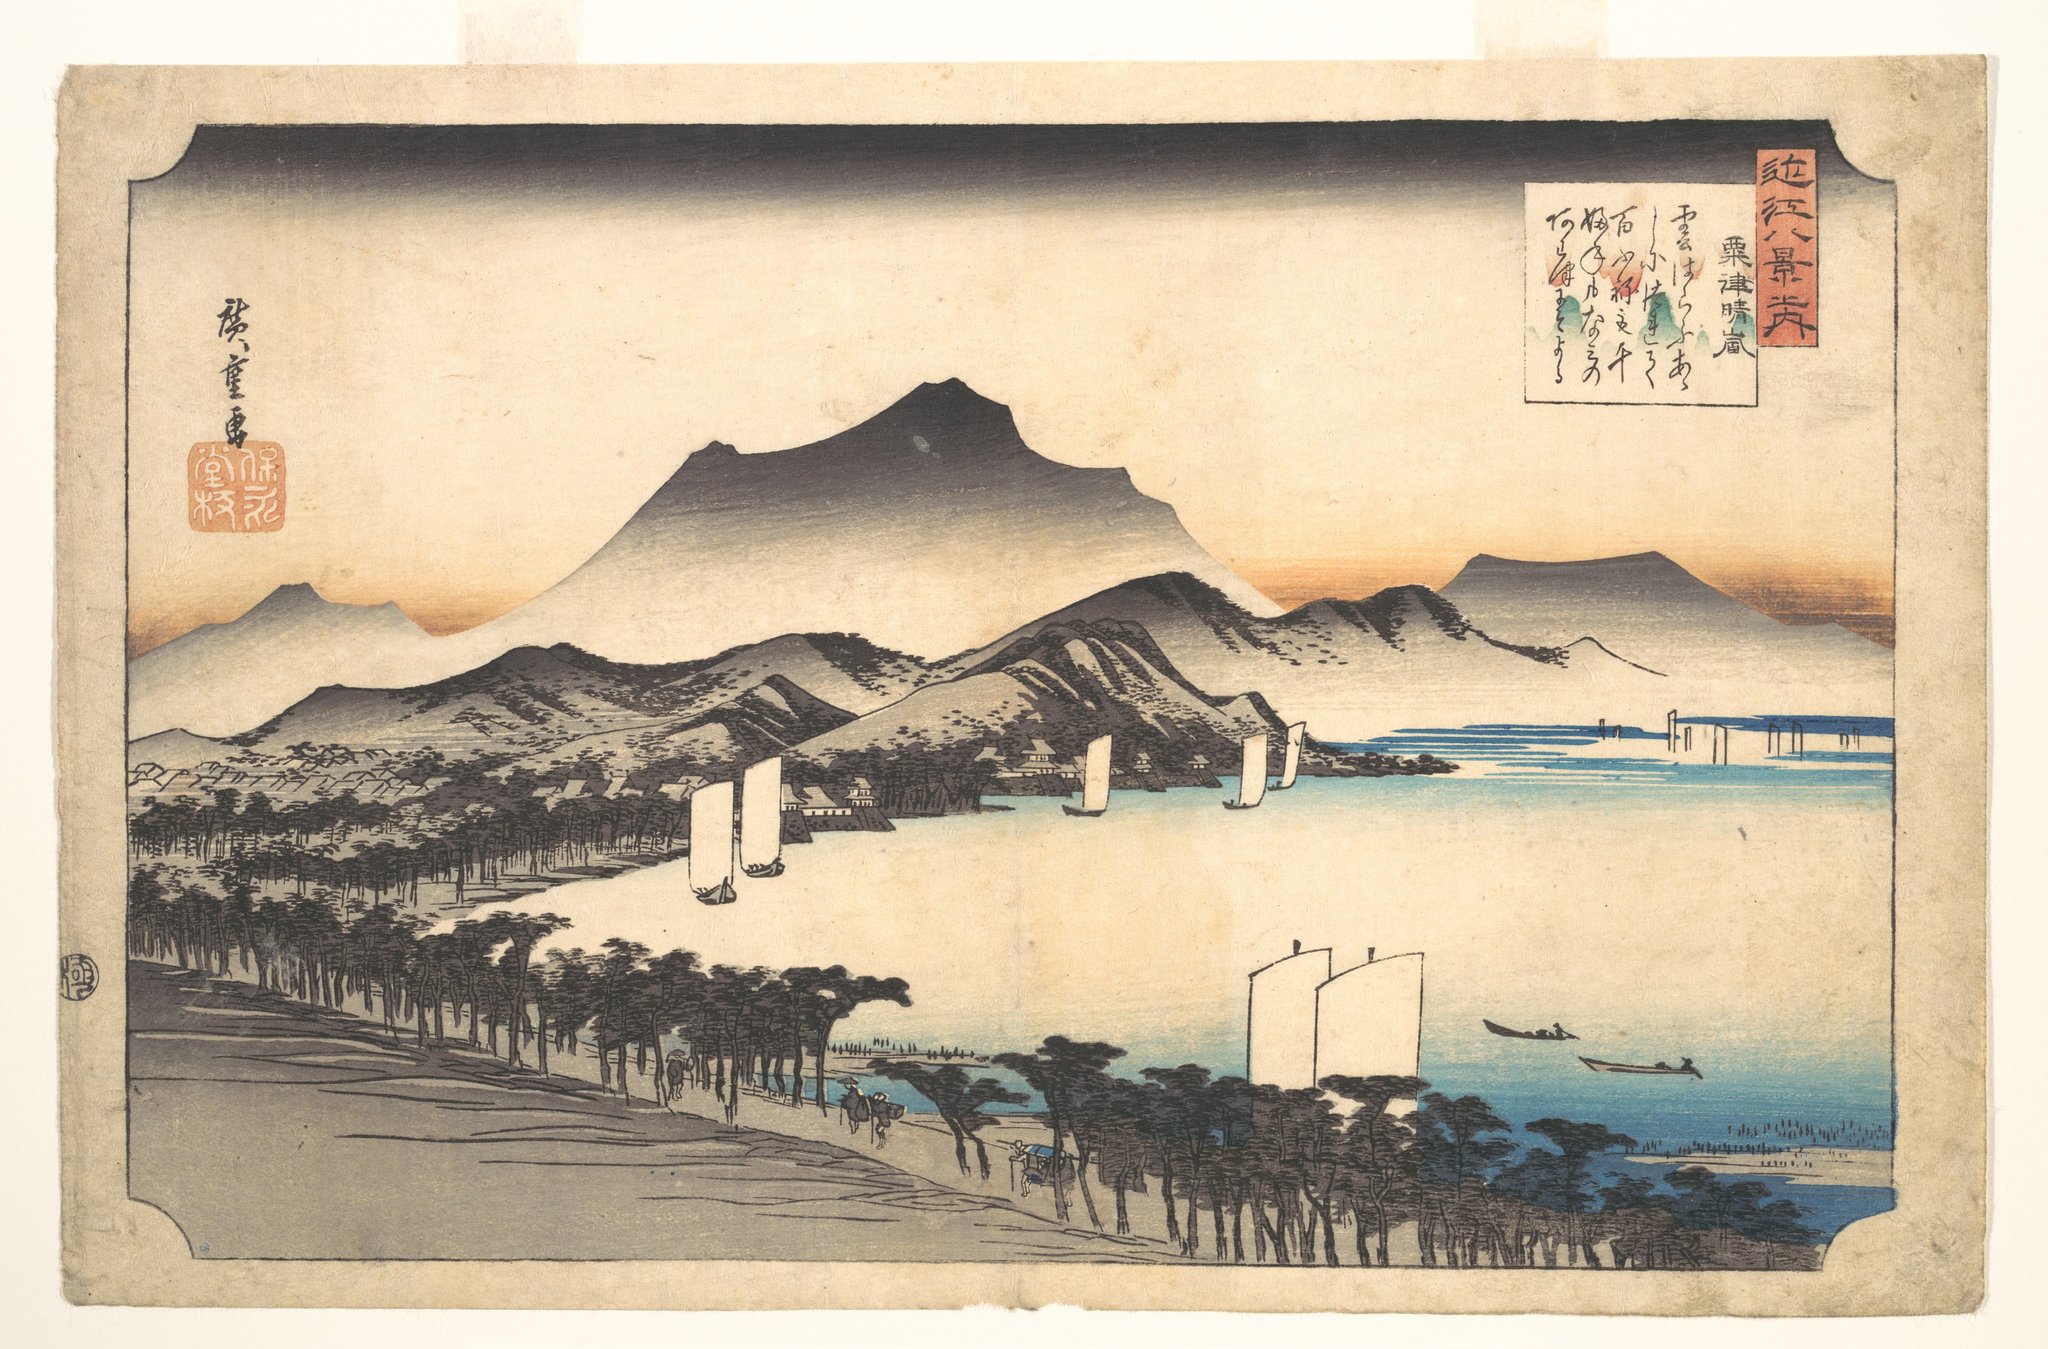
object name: print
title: Clearing Weather at Awazu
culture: japanese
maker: utagawa hiroshige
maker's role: artist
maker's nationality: japanese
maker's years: 1797-1858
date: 1797-1858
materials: ink, paper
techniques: woodblock print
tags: mountains,trees,boats